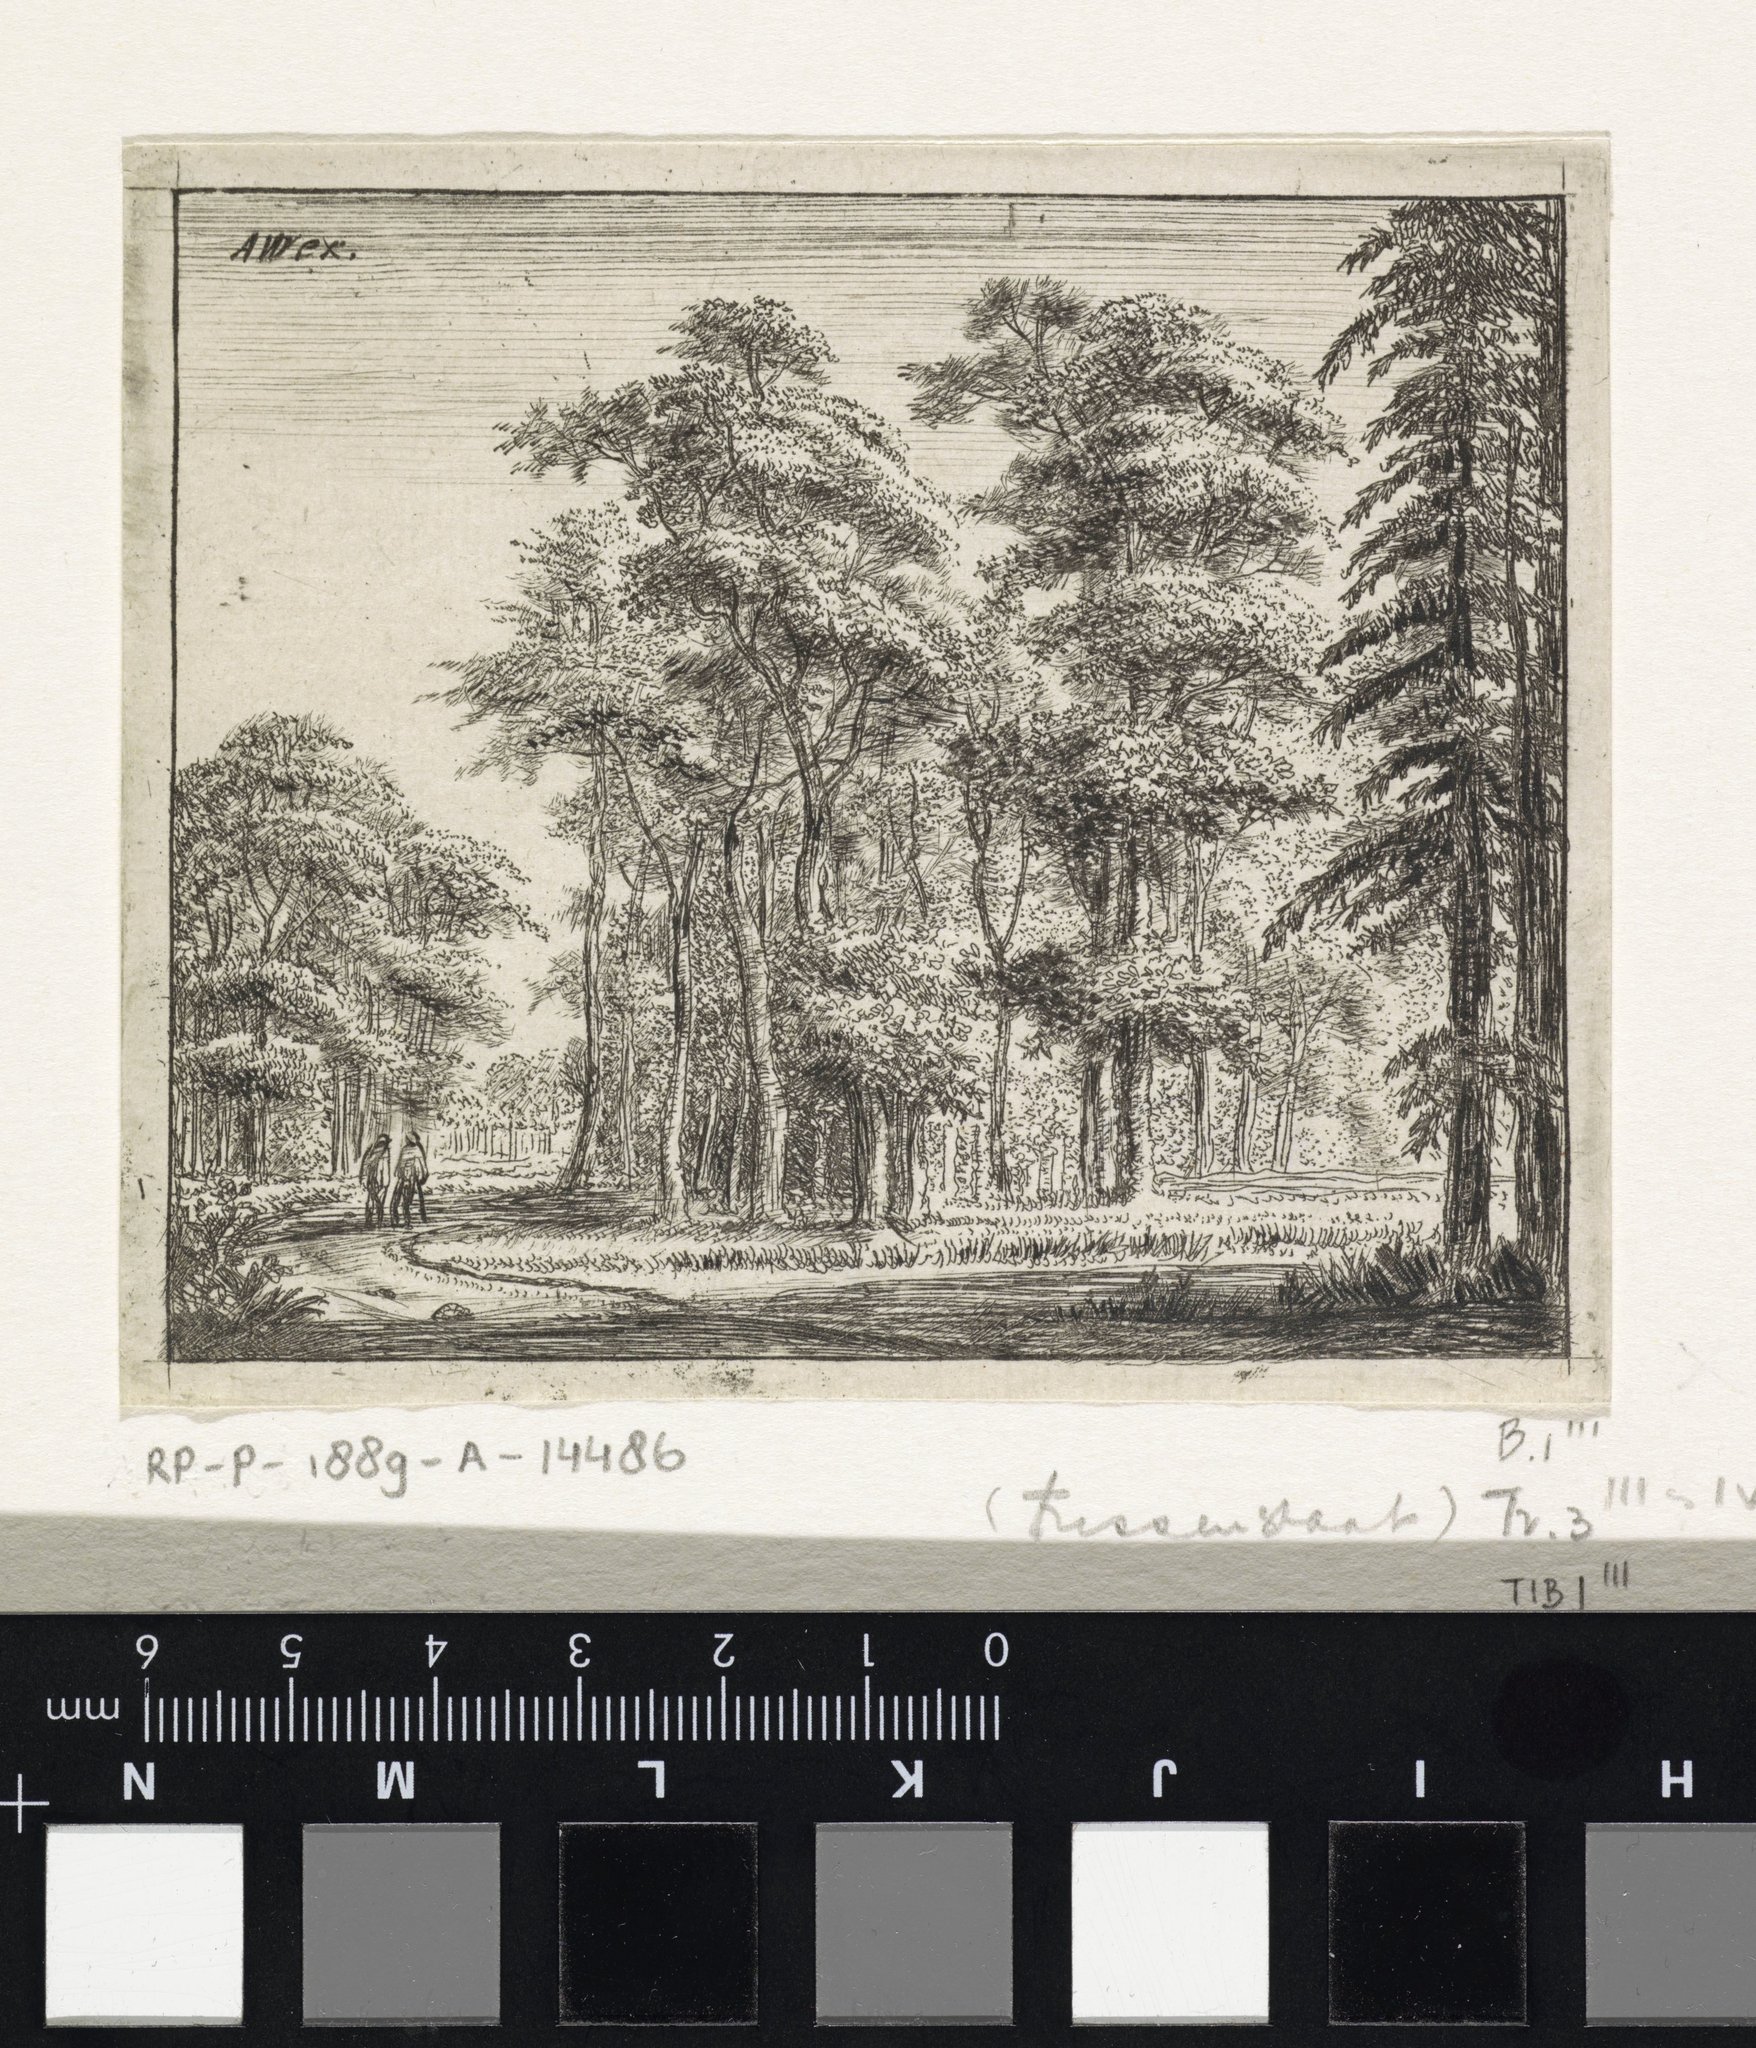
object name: print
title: Twee figuren op een kronkelpad in een bos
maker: anthonie waterloo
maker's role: draughtsman, painter, print maker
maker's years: 1609-1690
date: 1648-1663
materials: ink, paper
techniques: etching, pen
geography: amsterdam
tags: forest path or lane - hh - ideal landscapes (+ landscape with figures, staffage)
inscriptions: collector's mark: Lugt 2228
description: Zie Hollstein voor een volledig overzicht van de verschillende edities.